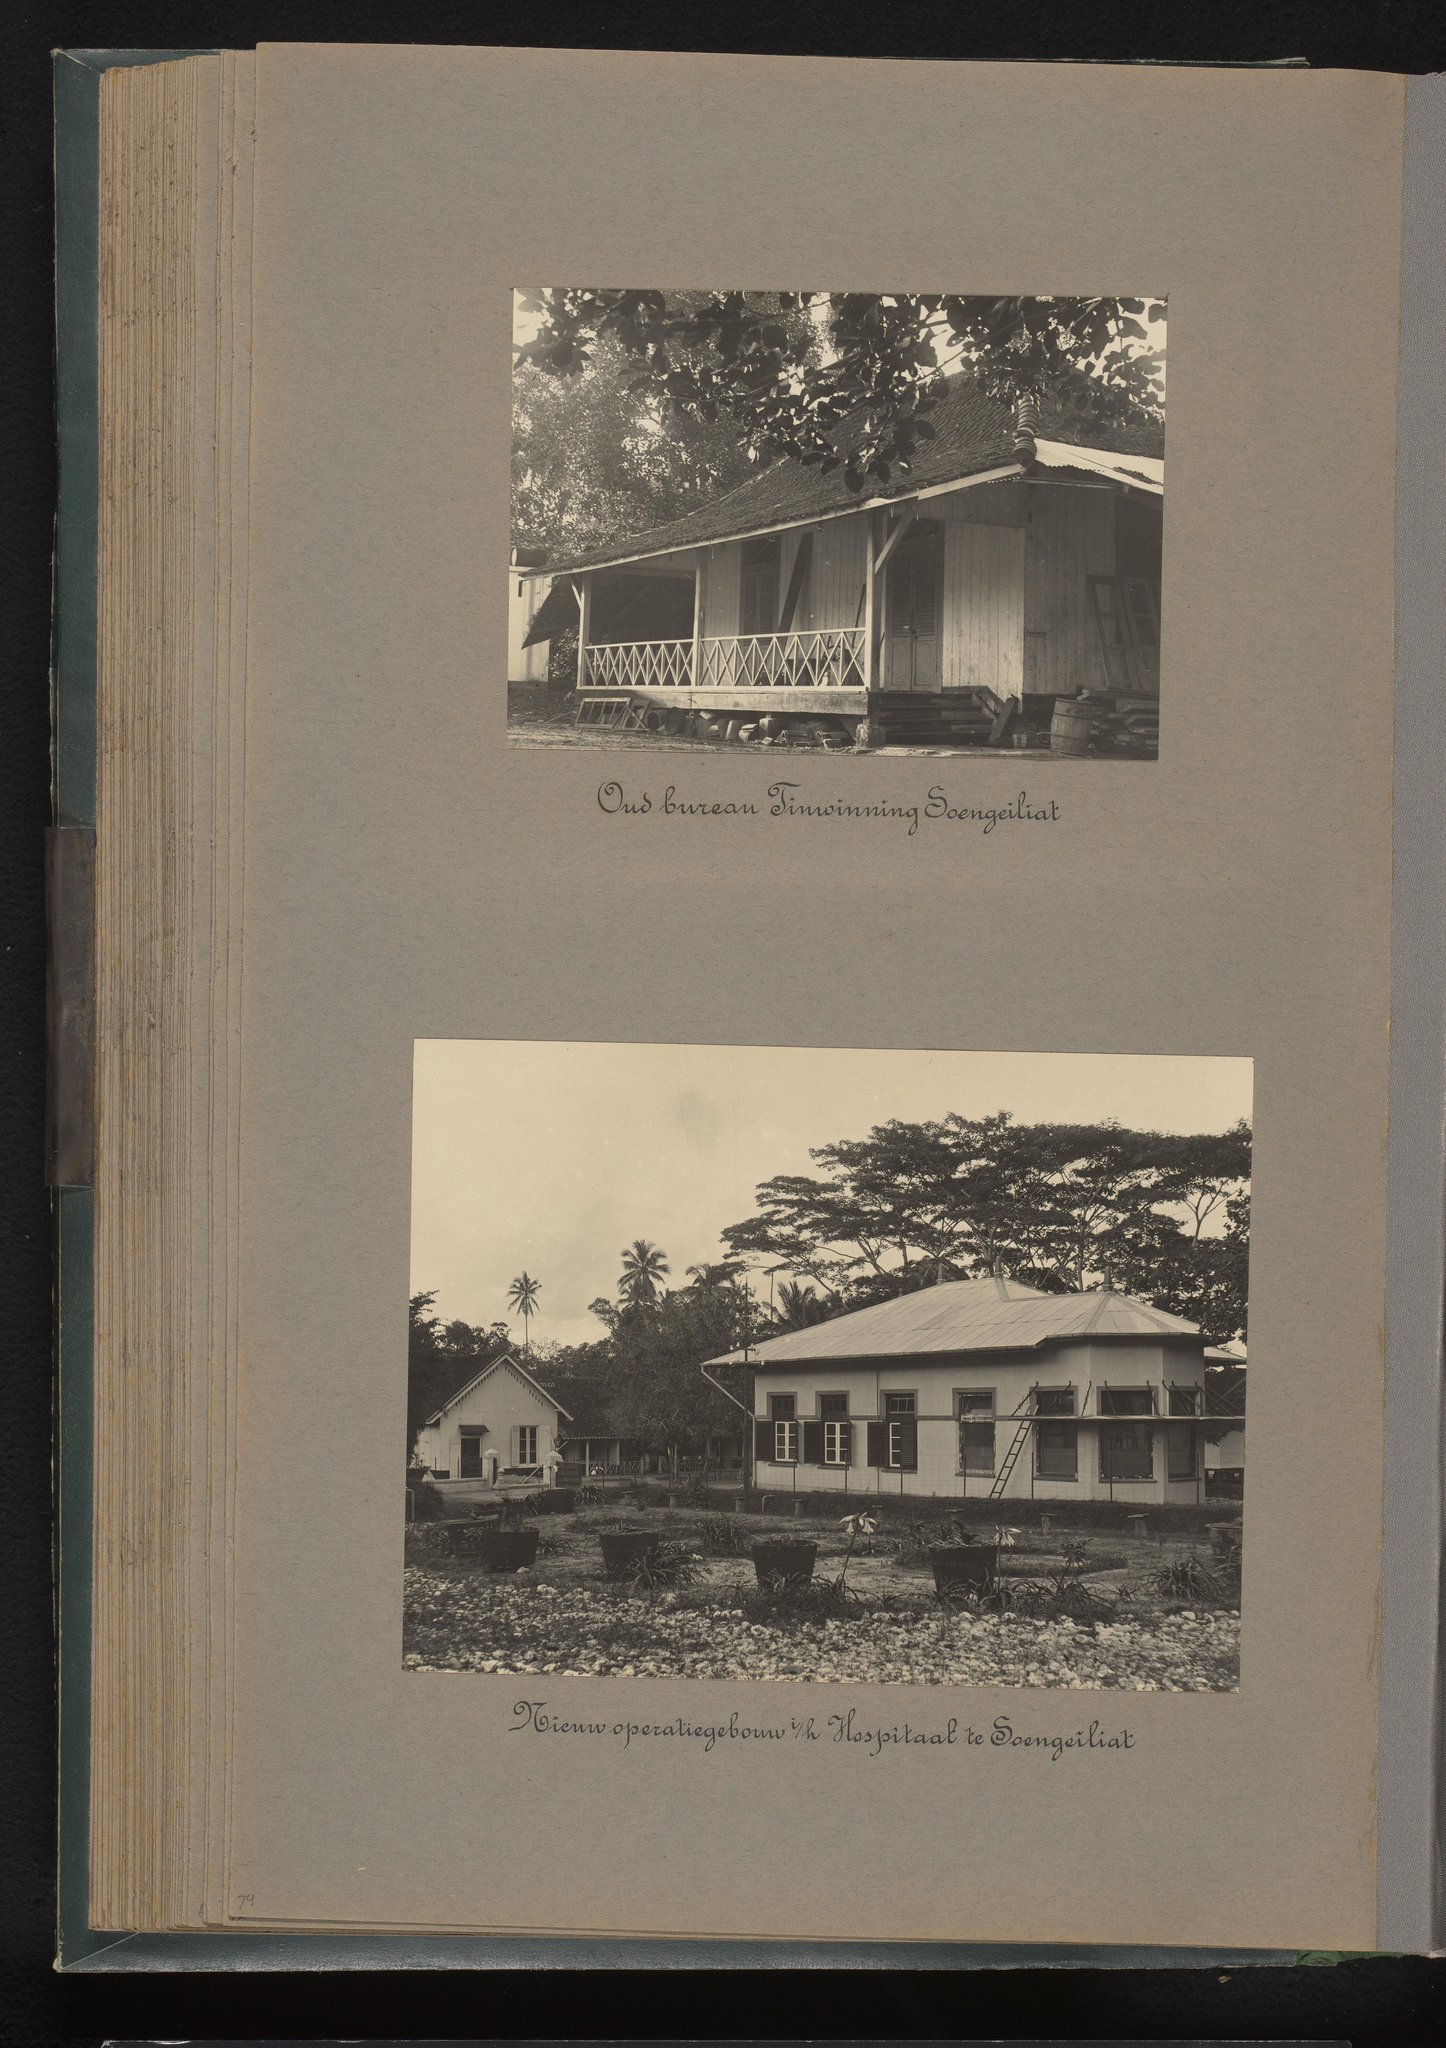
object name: photograph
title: Bureau en hospitaal van de Banka-tinwinning te Soengeiliat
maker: Anonymous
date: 1914-1919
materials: cardboard, photographic support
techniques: gelatin silver print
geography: bangka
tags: robert julius boers, colonial system, mining, hospital, exterior of industrial structures, factories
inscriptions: inscription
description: Albumblad met 2 foto's van het oude atelier en het hospitaal van de Banka-tinwinning te Soengeiliat. Onderdeel van het fotoalbum aangeboden aan Robert Julius Boers bij zijn vertrek naar Nederland in 1919 door het personeel van de Banka-tinwinning.